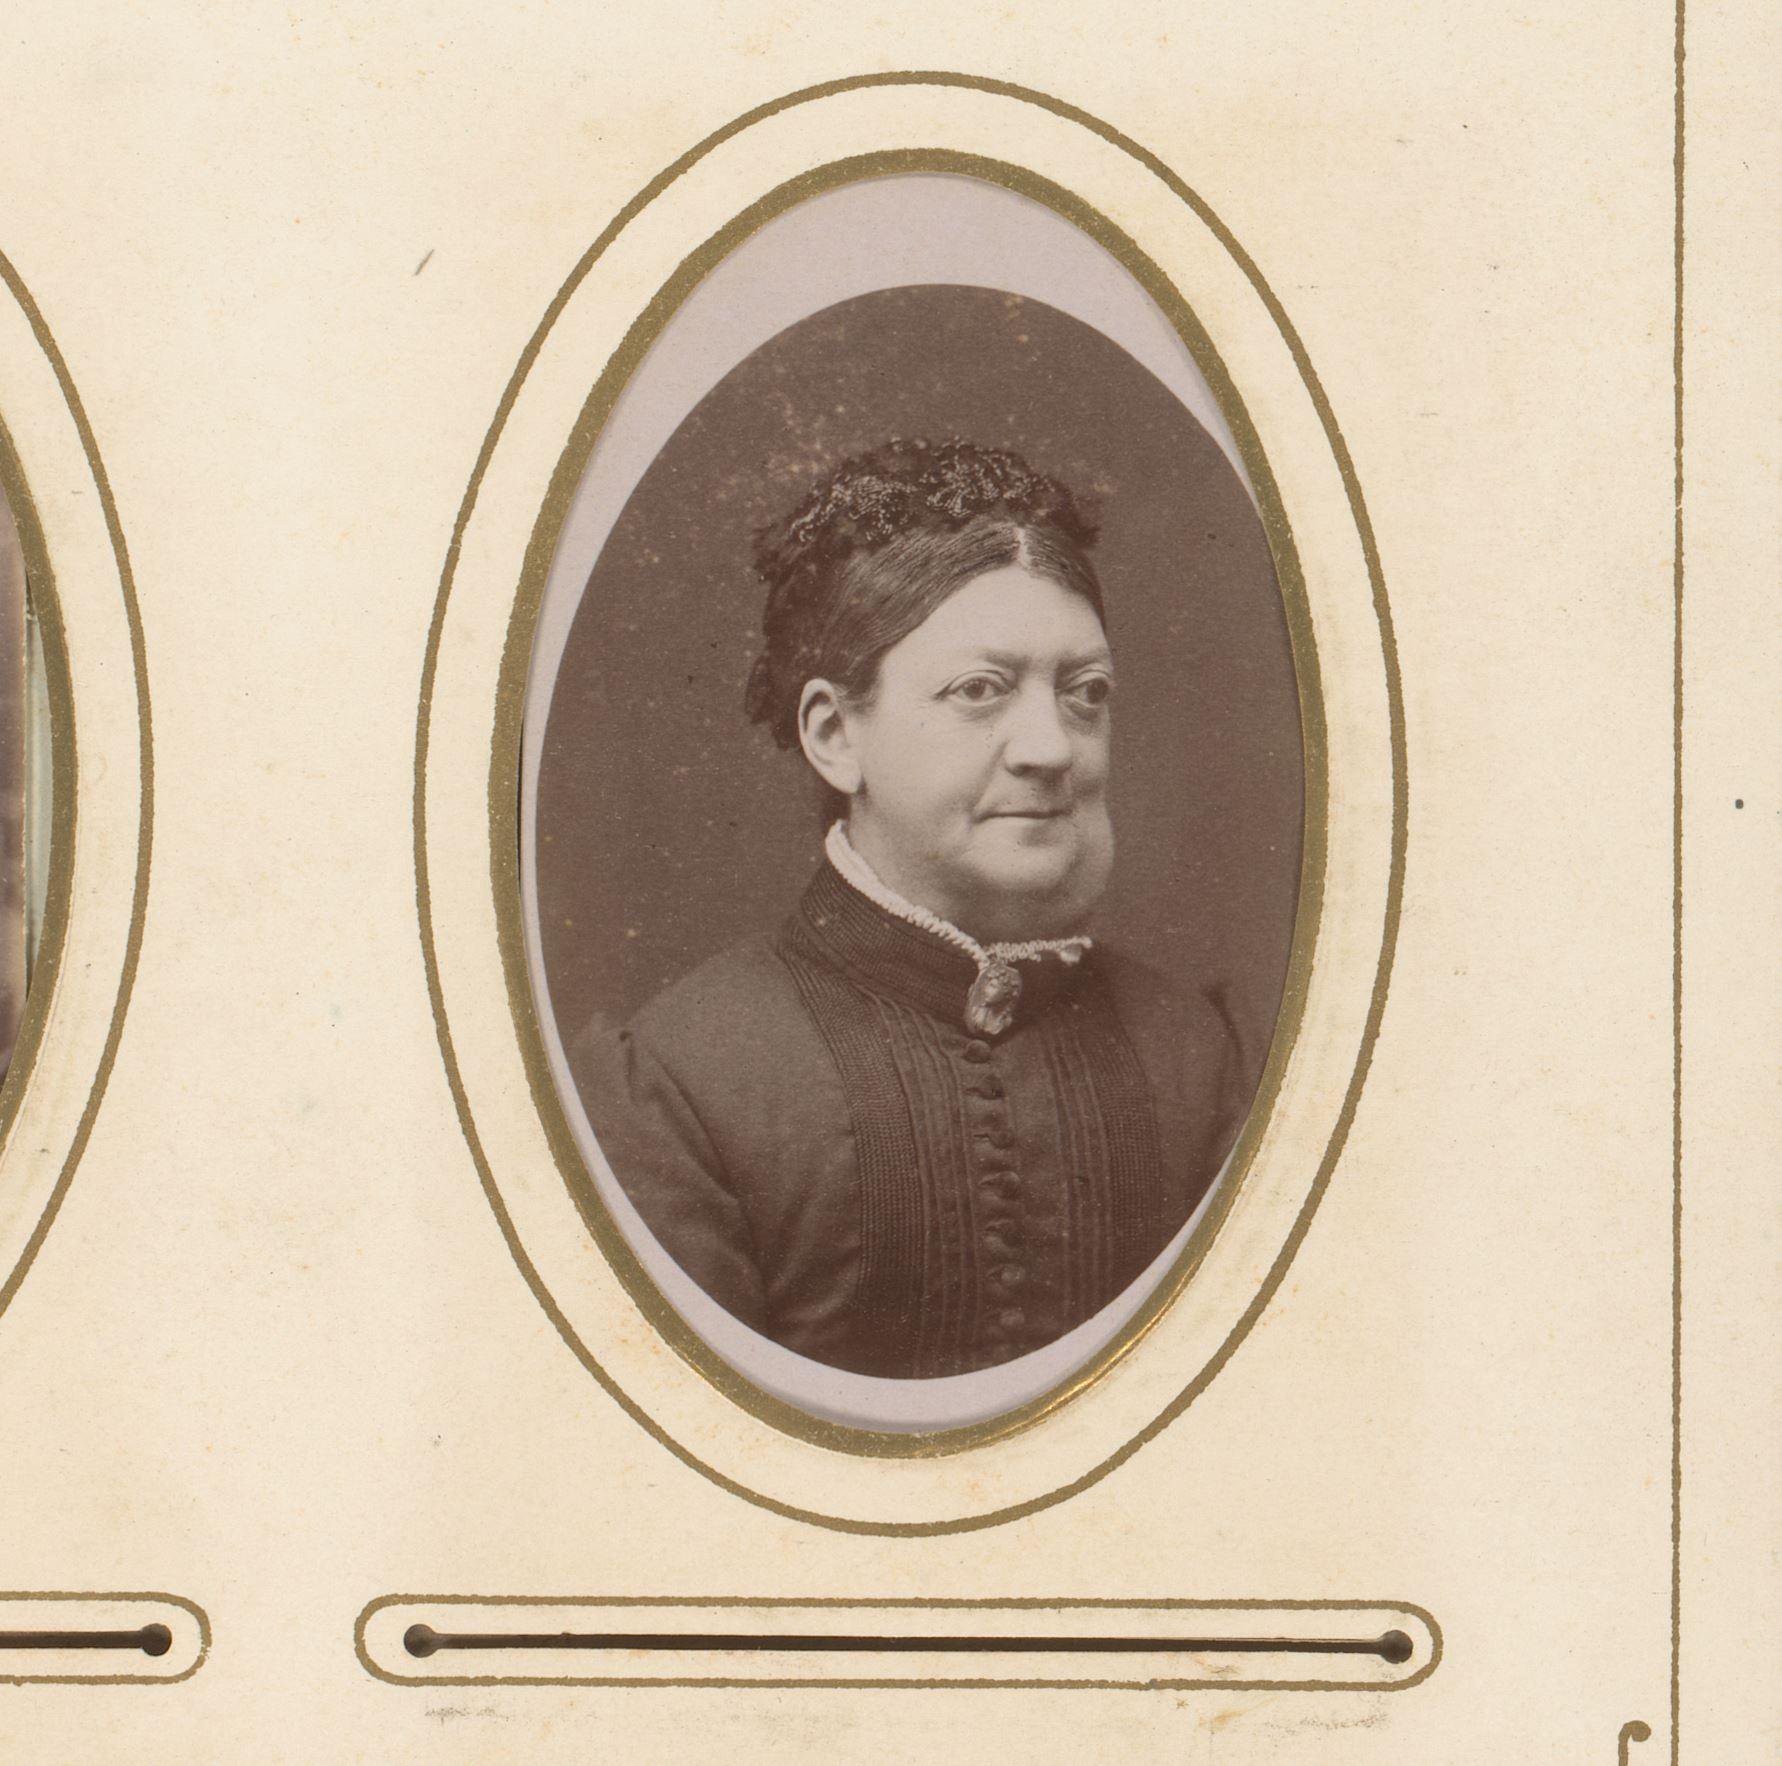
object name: carte de visite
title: Portret van een vrouw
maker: idanus hendrikus slaterus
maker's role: fotograaf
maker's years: 1846-1921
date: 1868-1909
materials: cardboard, photographic support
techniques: albumen print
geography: leeuwarden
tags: historical persons - bb - woman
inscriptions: inscription: ‘Photographie/ Instantanée/ I. H. Slaterus/ Leeuwarden/ Weerd.’